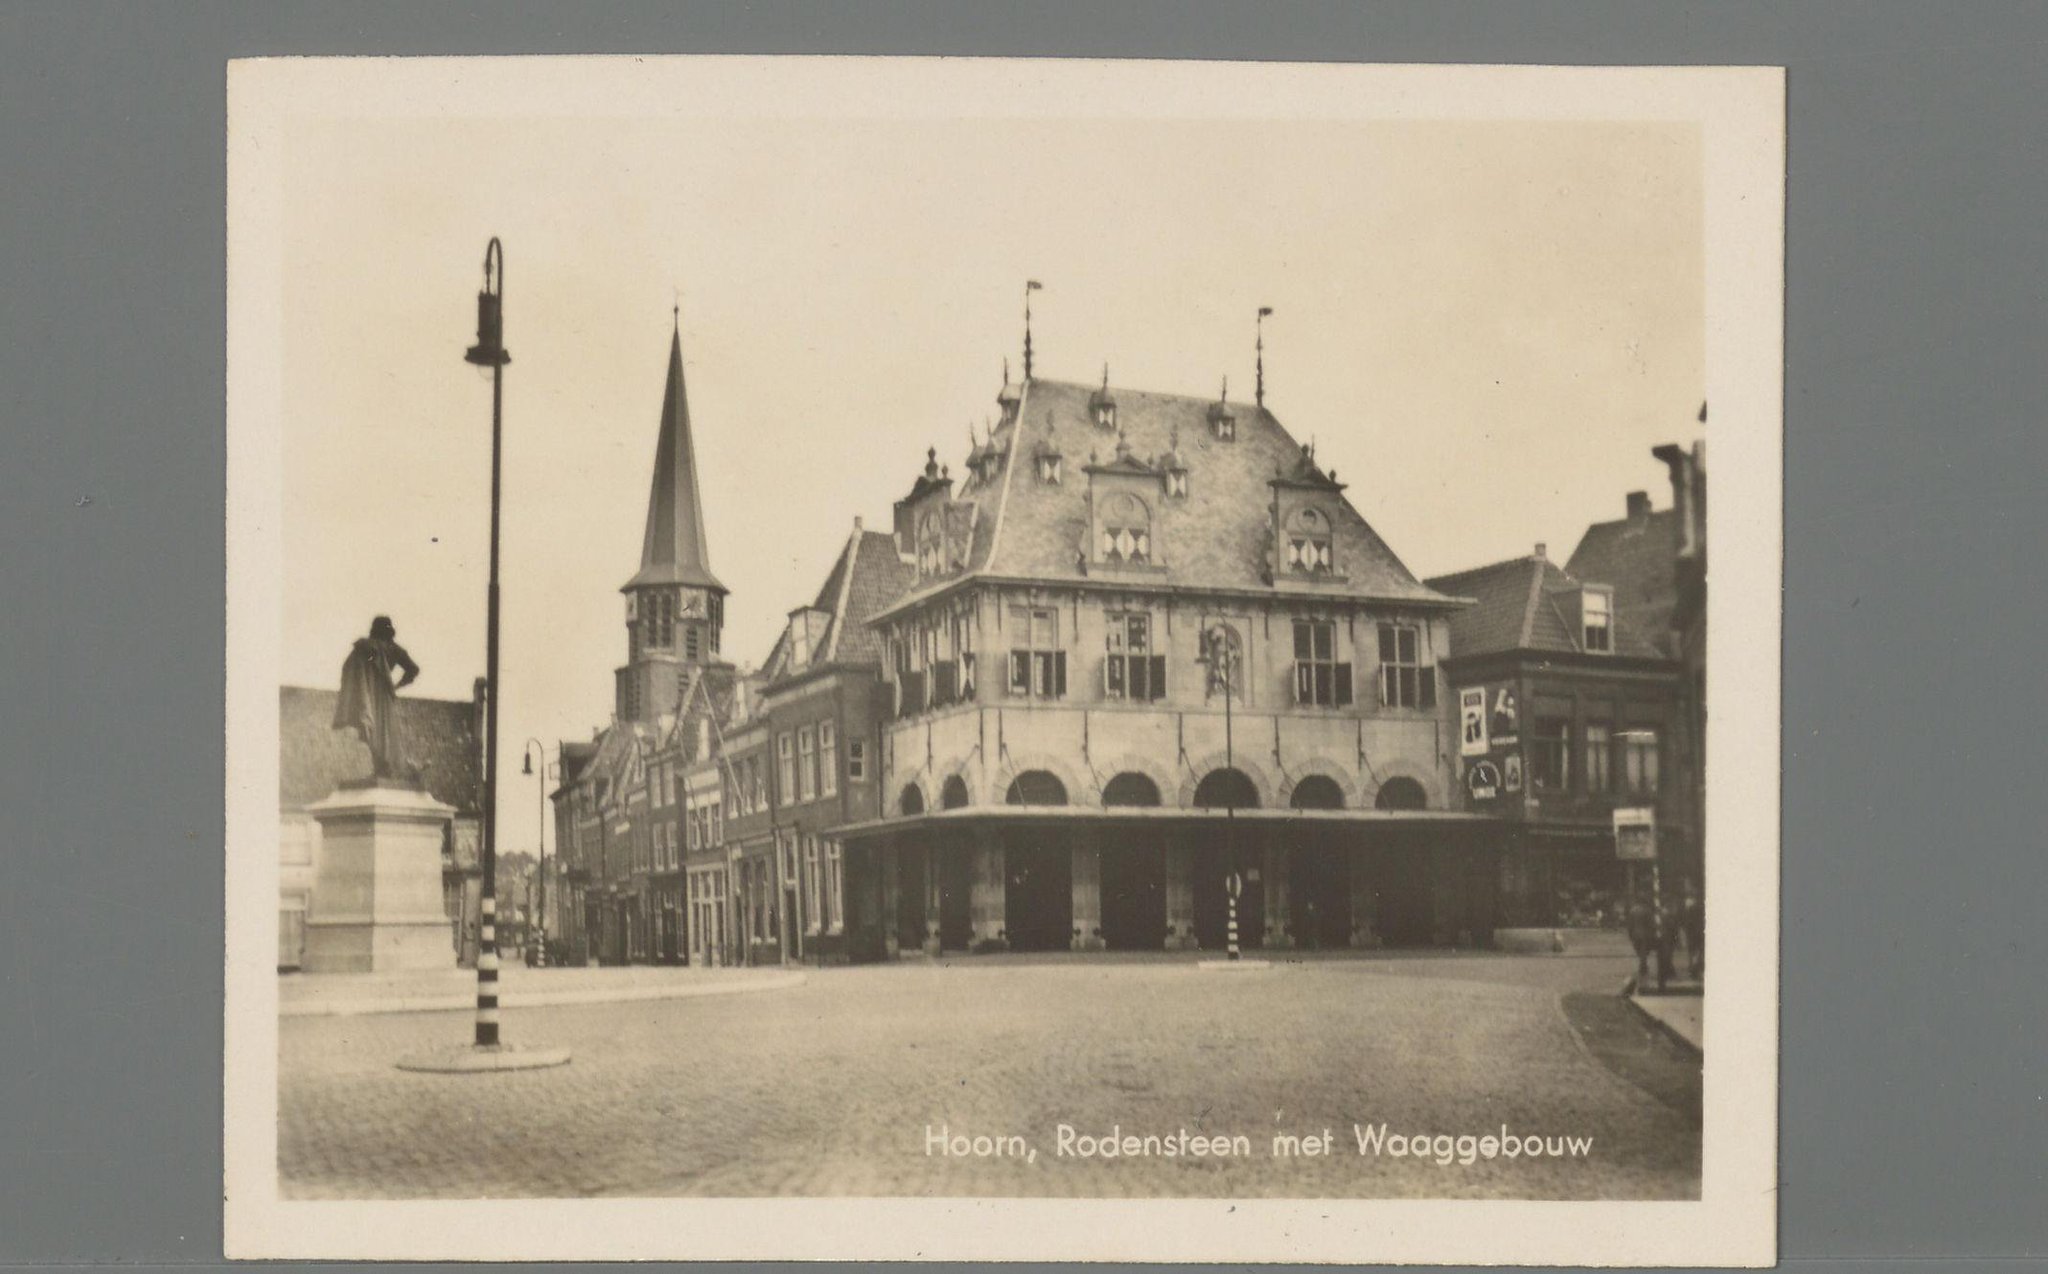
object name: photograph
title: Hoorn, Rodensteen met Waaggebouw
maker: Anonymous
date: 1900-1950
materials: paper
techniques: gelatin silver print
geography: hoorn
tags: square, place, circus, etc., façade (of house or building)